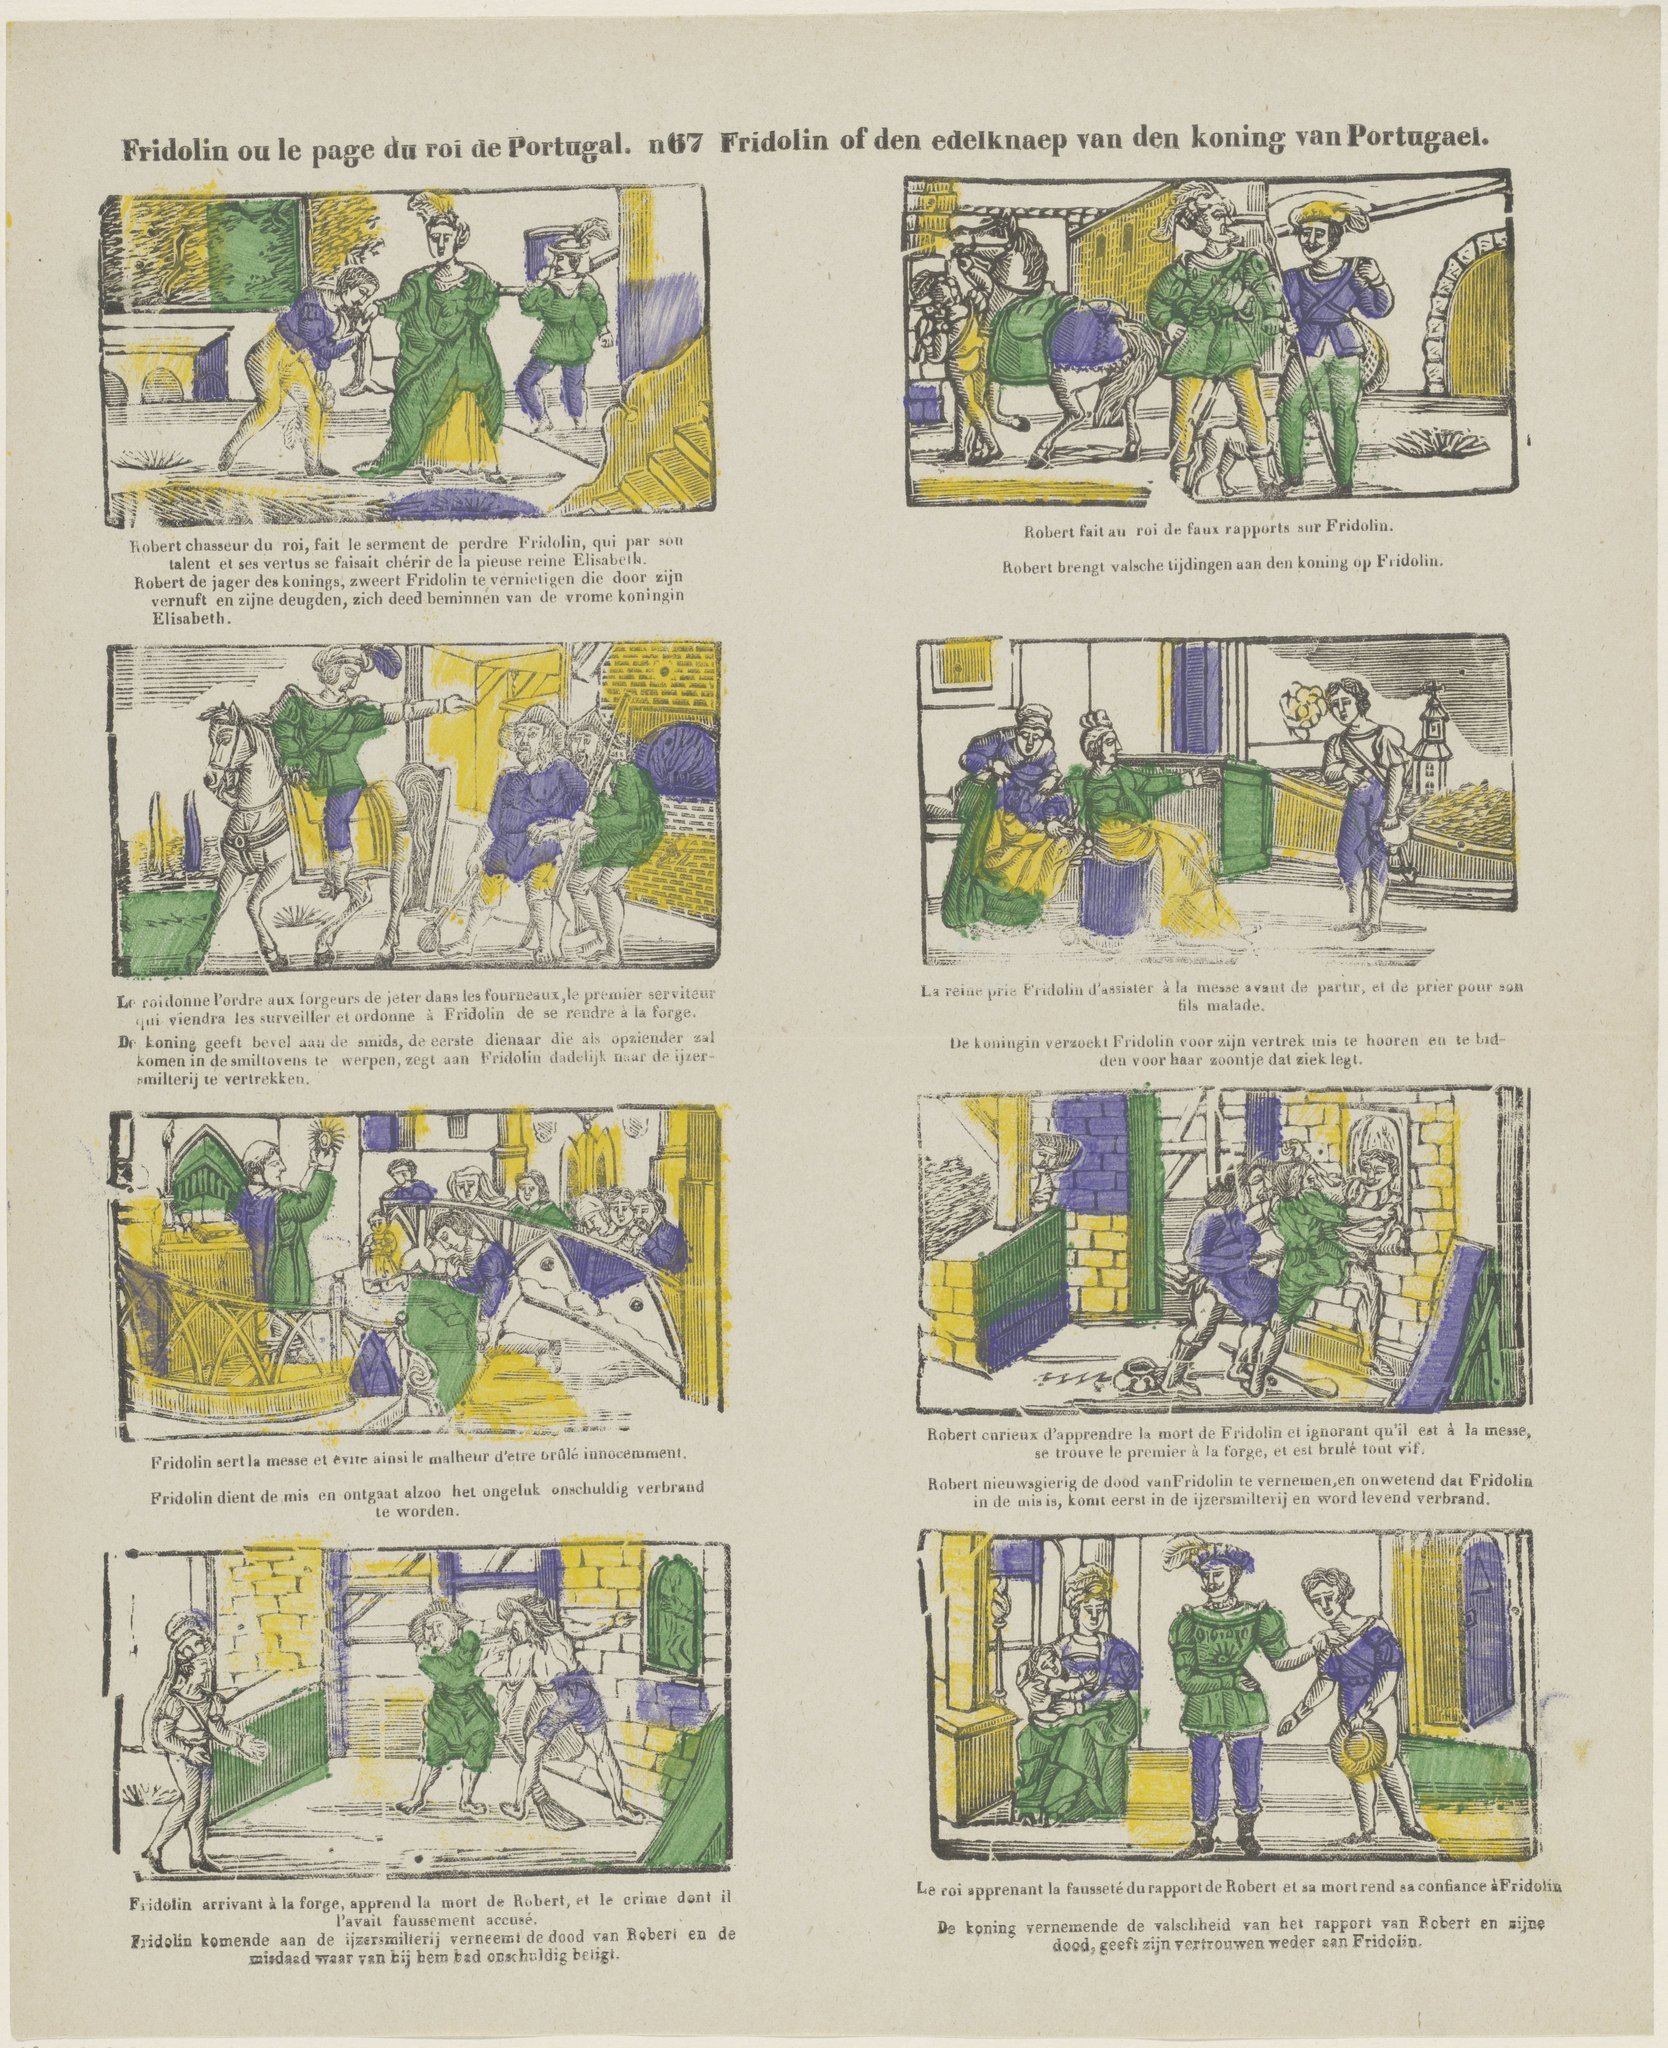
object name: print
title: Fridolin ou le page du roi de Portugal / Fridolin of den edelknaep van den koning van Portugael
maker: Anonymous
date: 1856-1900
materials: paper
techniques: colour, letterpress printing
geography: netherlands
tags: tales and fairy tales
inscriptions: collector's mark: Lugt 2760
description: Blad met 12 voorstellingen uit het verhaal van Fridolin, die door Robert vals wordt beschuldigd. De koning van Portugal beveelt de smid de eerste persoon die binnenkomt in de oven te werpen, en stuurt Fridolin naar hem toe. Maar deze ontkomt doordat hij eerst naar de mis gaat. Robert ondergaat Fridolins lot. Onder elke afbeelding een onderschrift in het Nederlands en in het Frans. Genummerd midden boven: n 67.